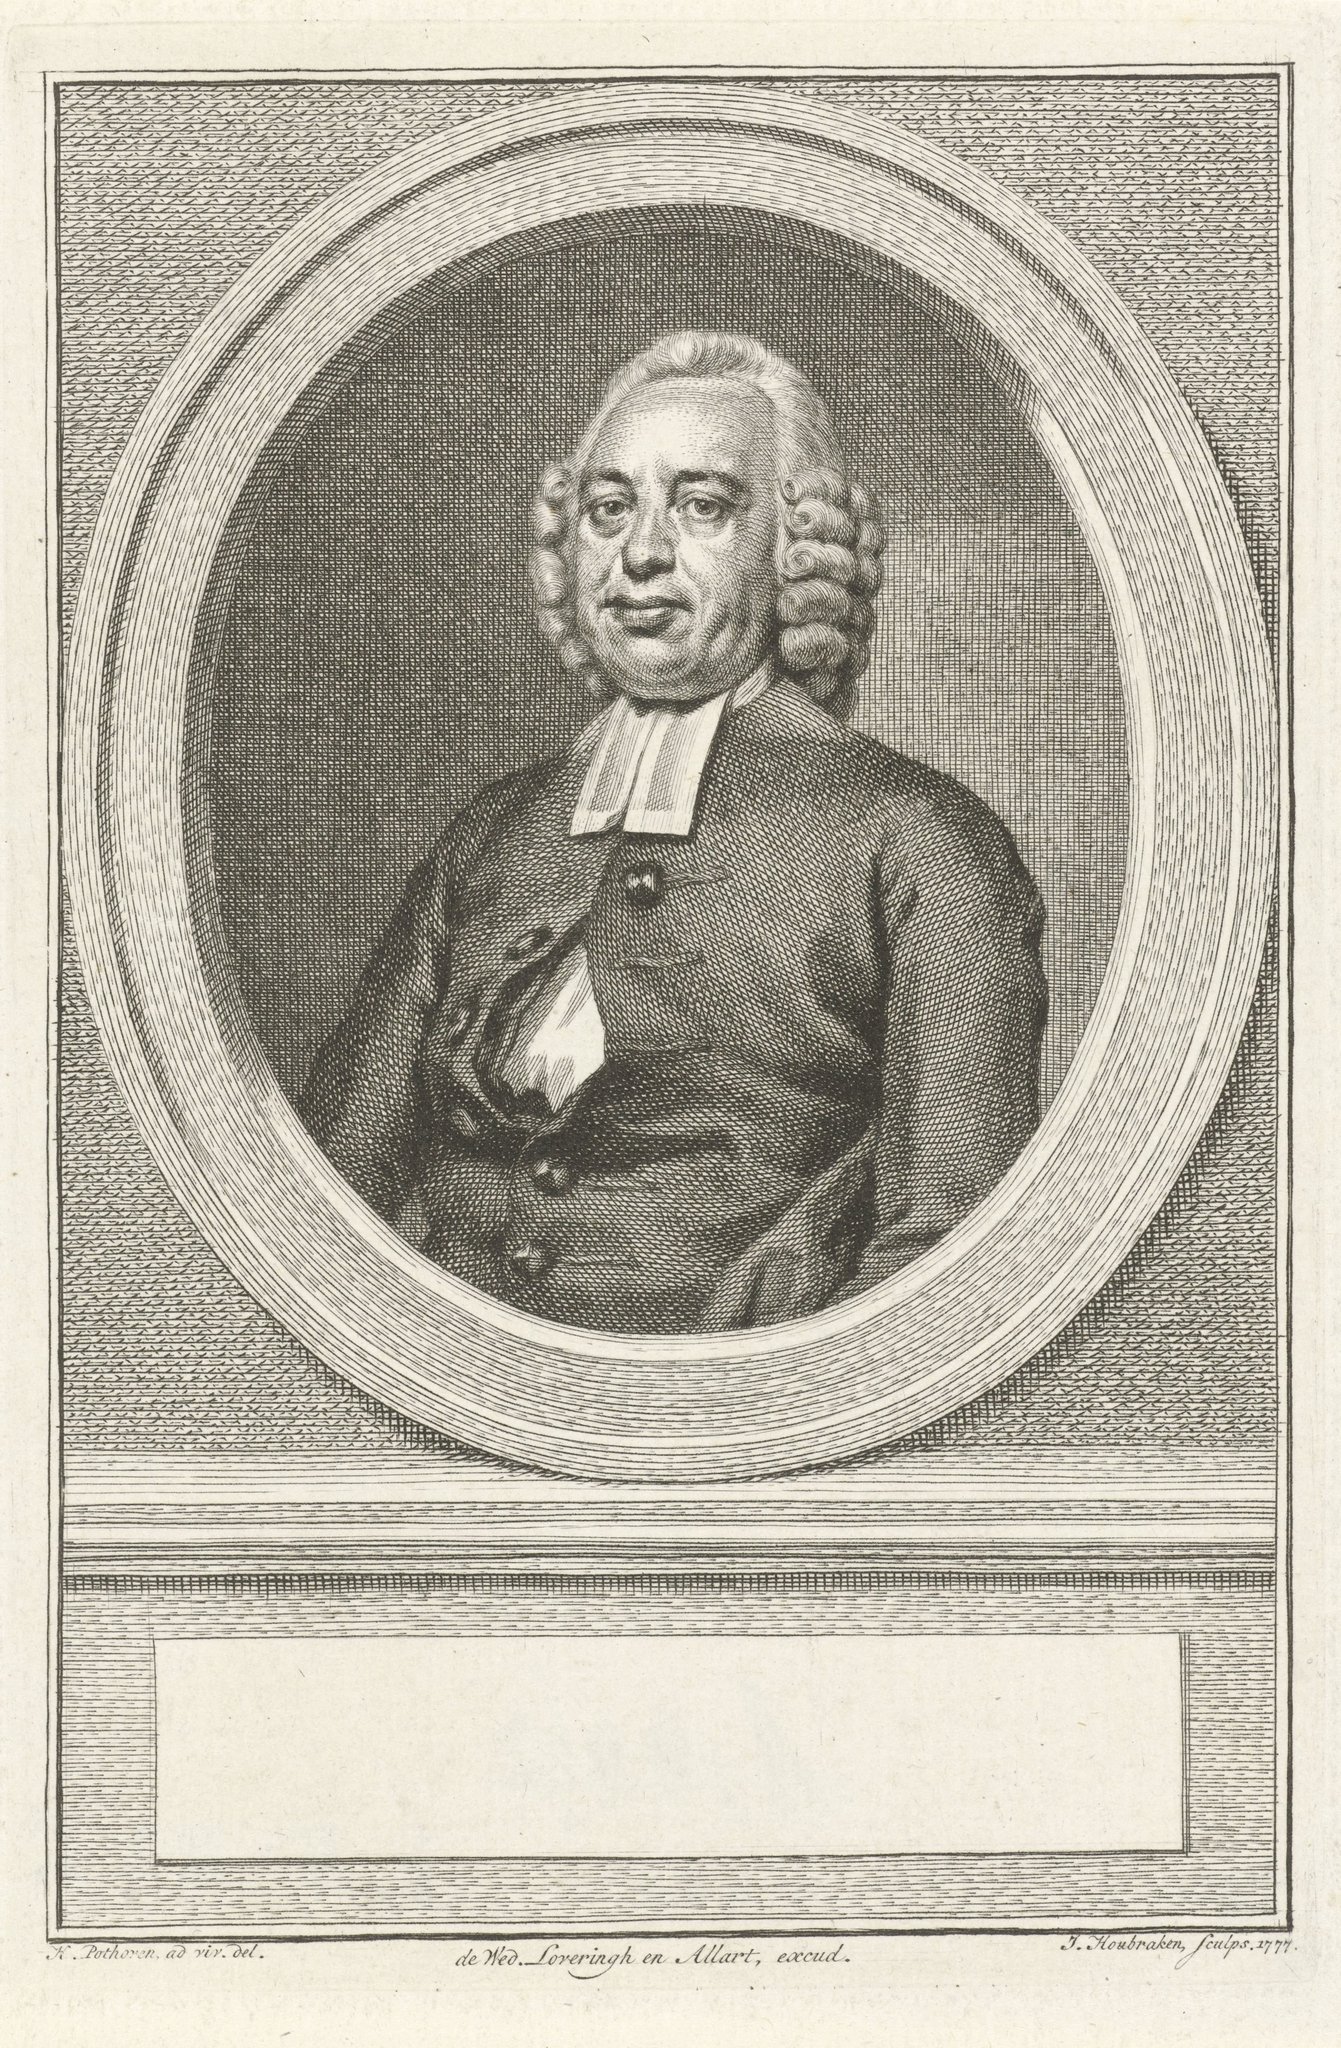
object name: print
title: Portret van Josua van Iperen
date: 1777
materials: paper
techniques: engraving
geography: amsterdam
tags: middelburg, batavia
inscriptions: collector's mark: Lugt 2228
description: Proefdruk van de prent volgens Ver Huell gebruikt in: Josua van Iperen, Kerkelyke historie van het psalm-gezang der christenen (...) en inzonderheid van onze verbeterde Nederduitsche psalmberyminge. Amsterdam: wed. Loveringh en Allart, 1777. Deel 2: J. Allart, 1778.